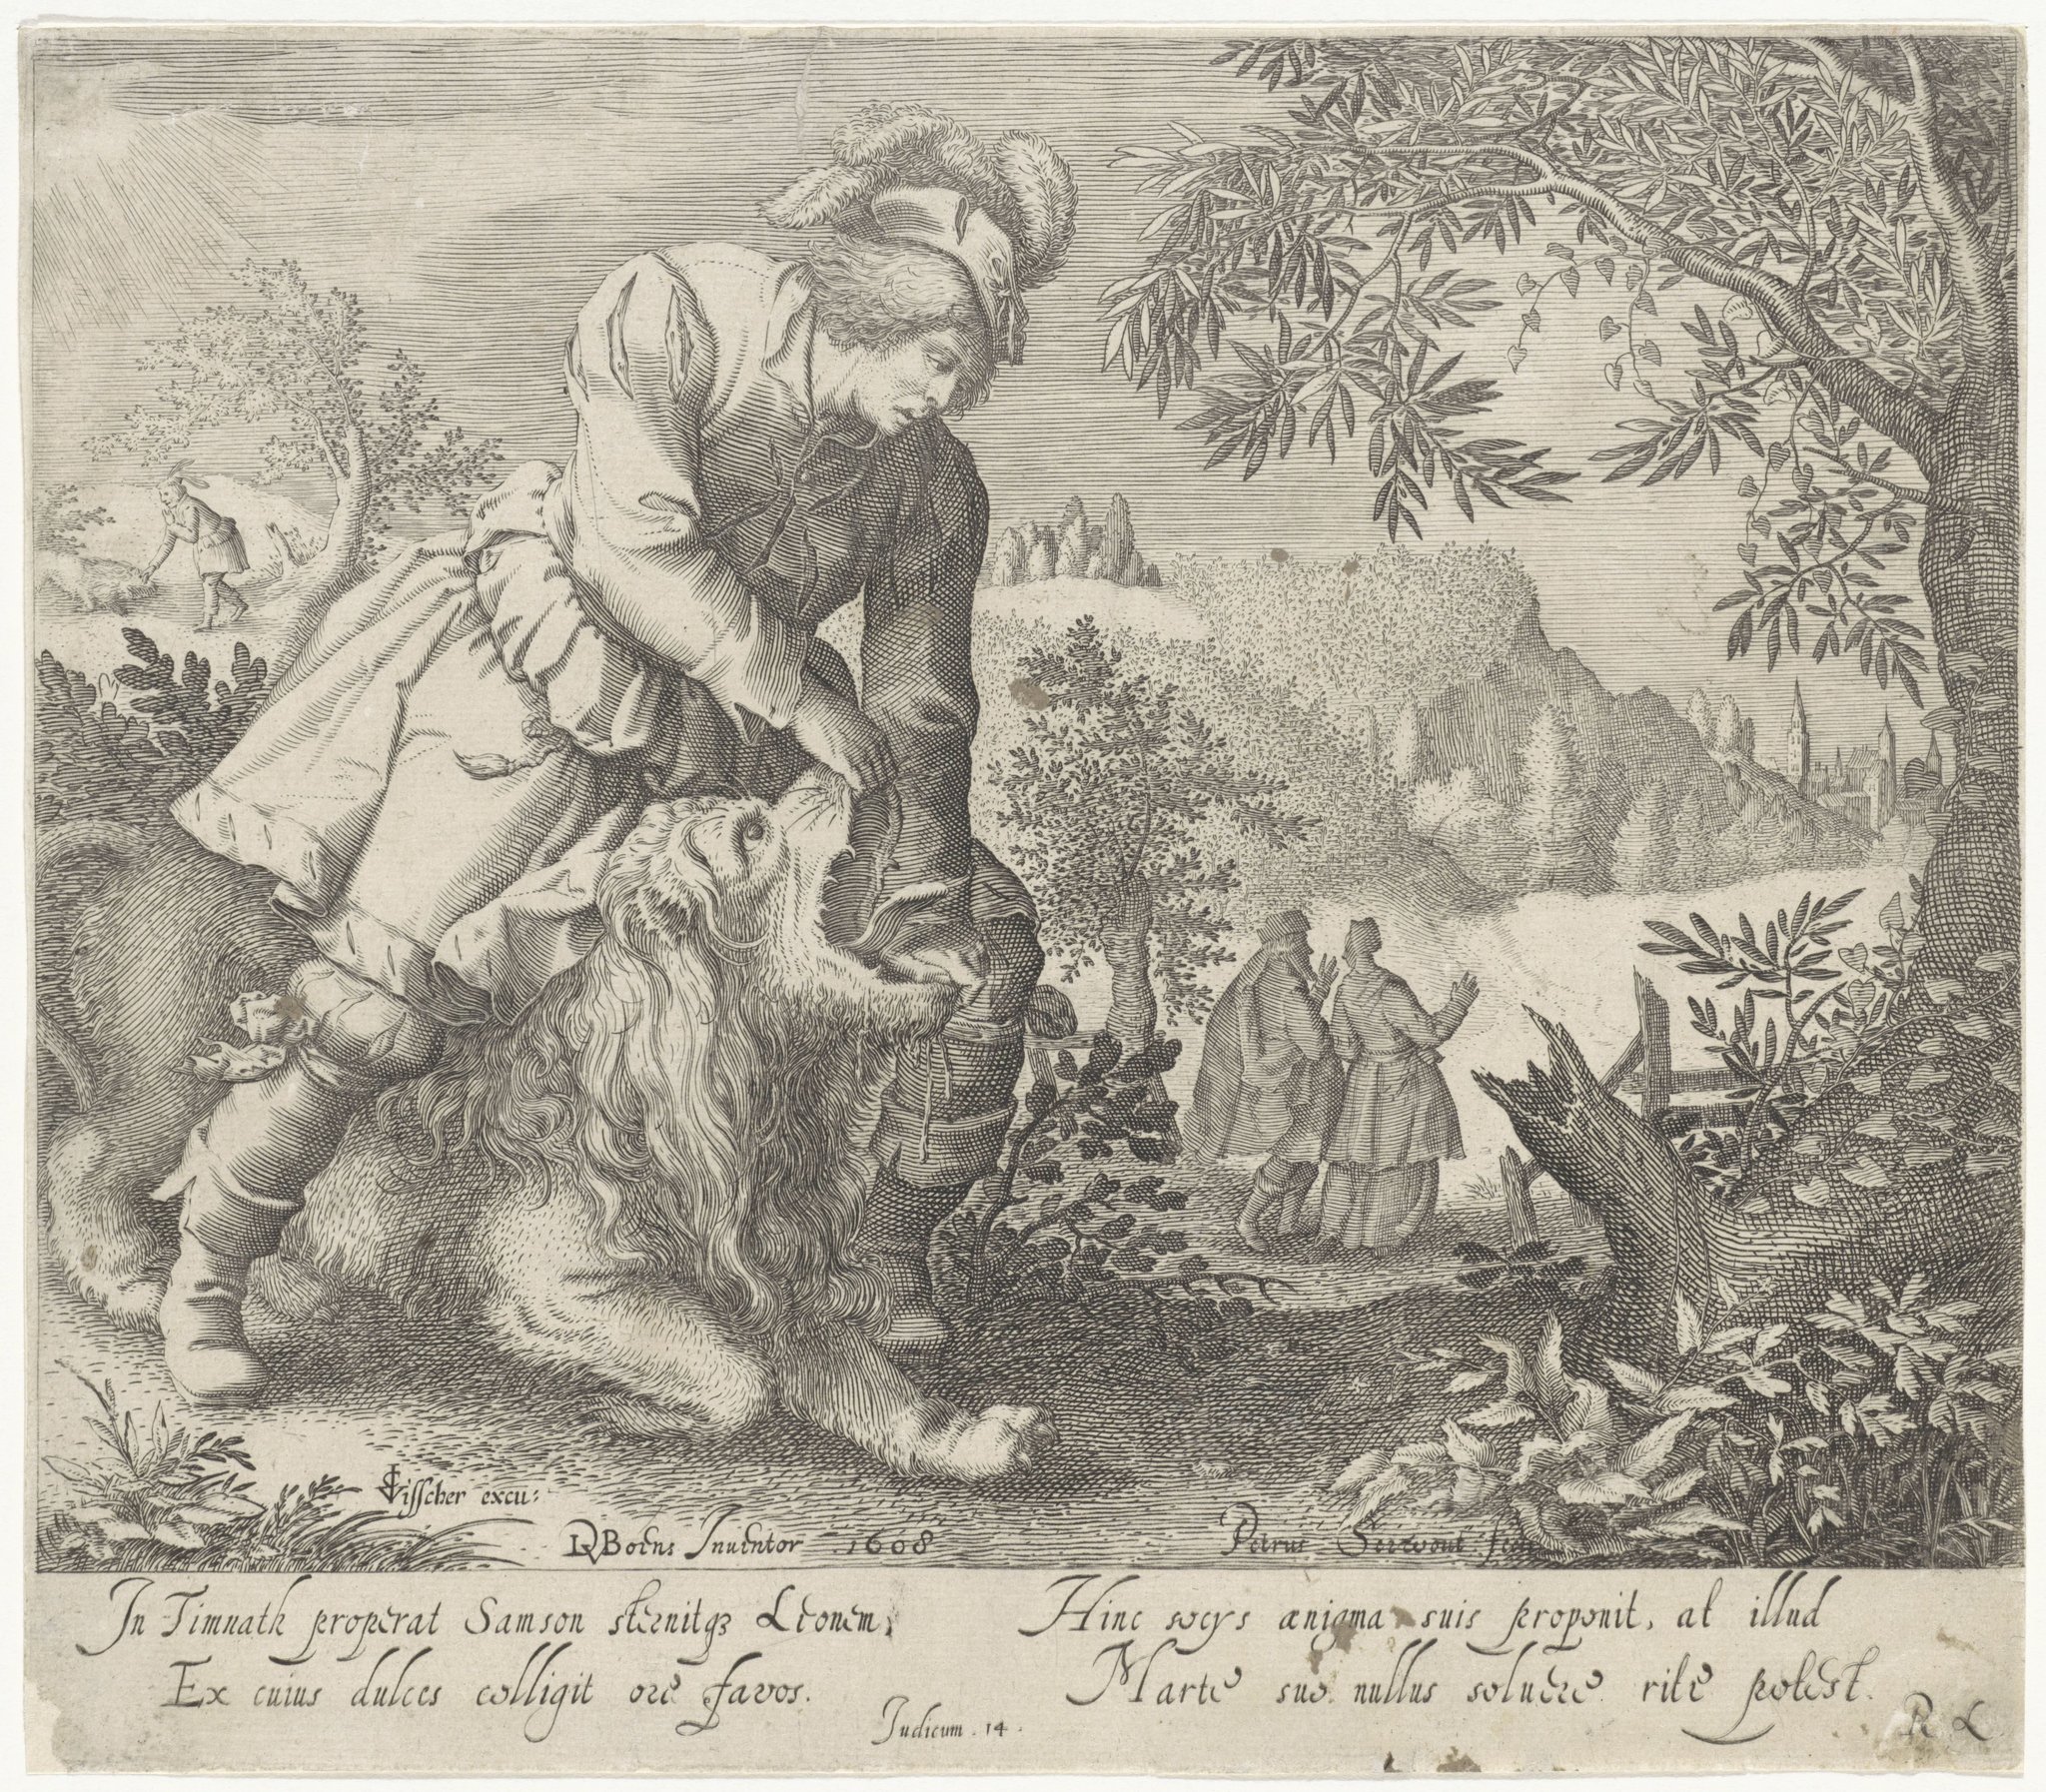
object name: print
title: Simson en de leeuw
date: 1608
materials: paper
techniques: engraving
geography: amsterdam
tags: samson kills the lion with his bare hands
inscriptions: collector's mark: Lugt 2228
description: Simson staat schrijliings over de leeuw en trekt zijn bek open. Op de achtergrond links staat Simson bij de dode leeuw; hij haalt honing uit het lichaam van het beest. Rechts staan zijn vader en moeder. Onder de prent vier versregels in het Latijn en eenverwijzing naar Richt. 14.